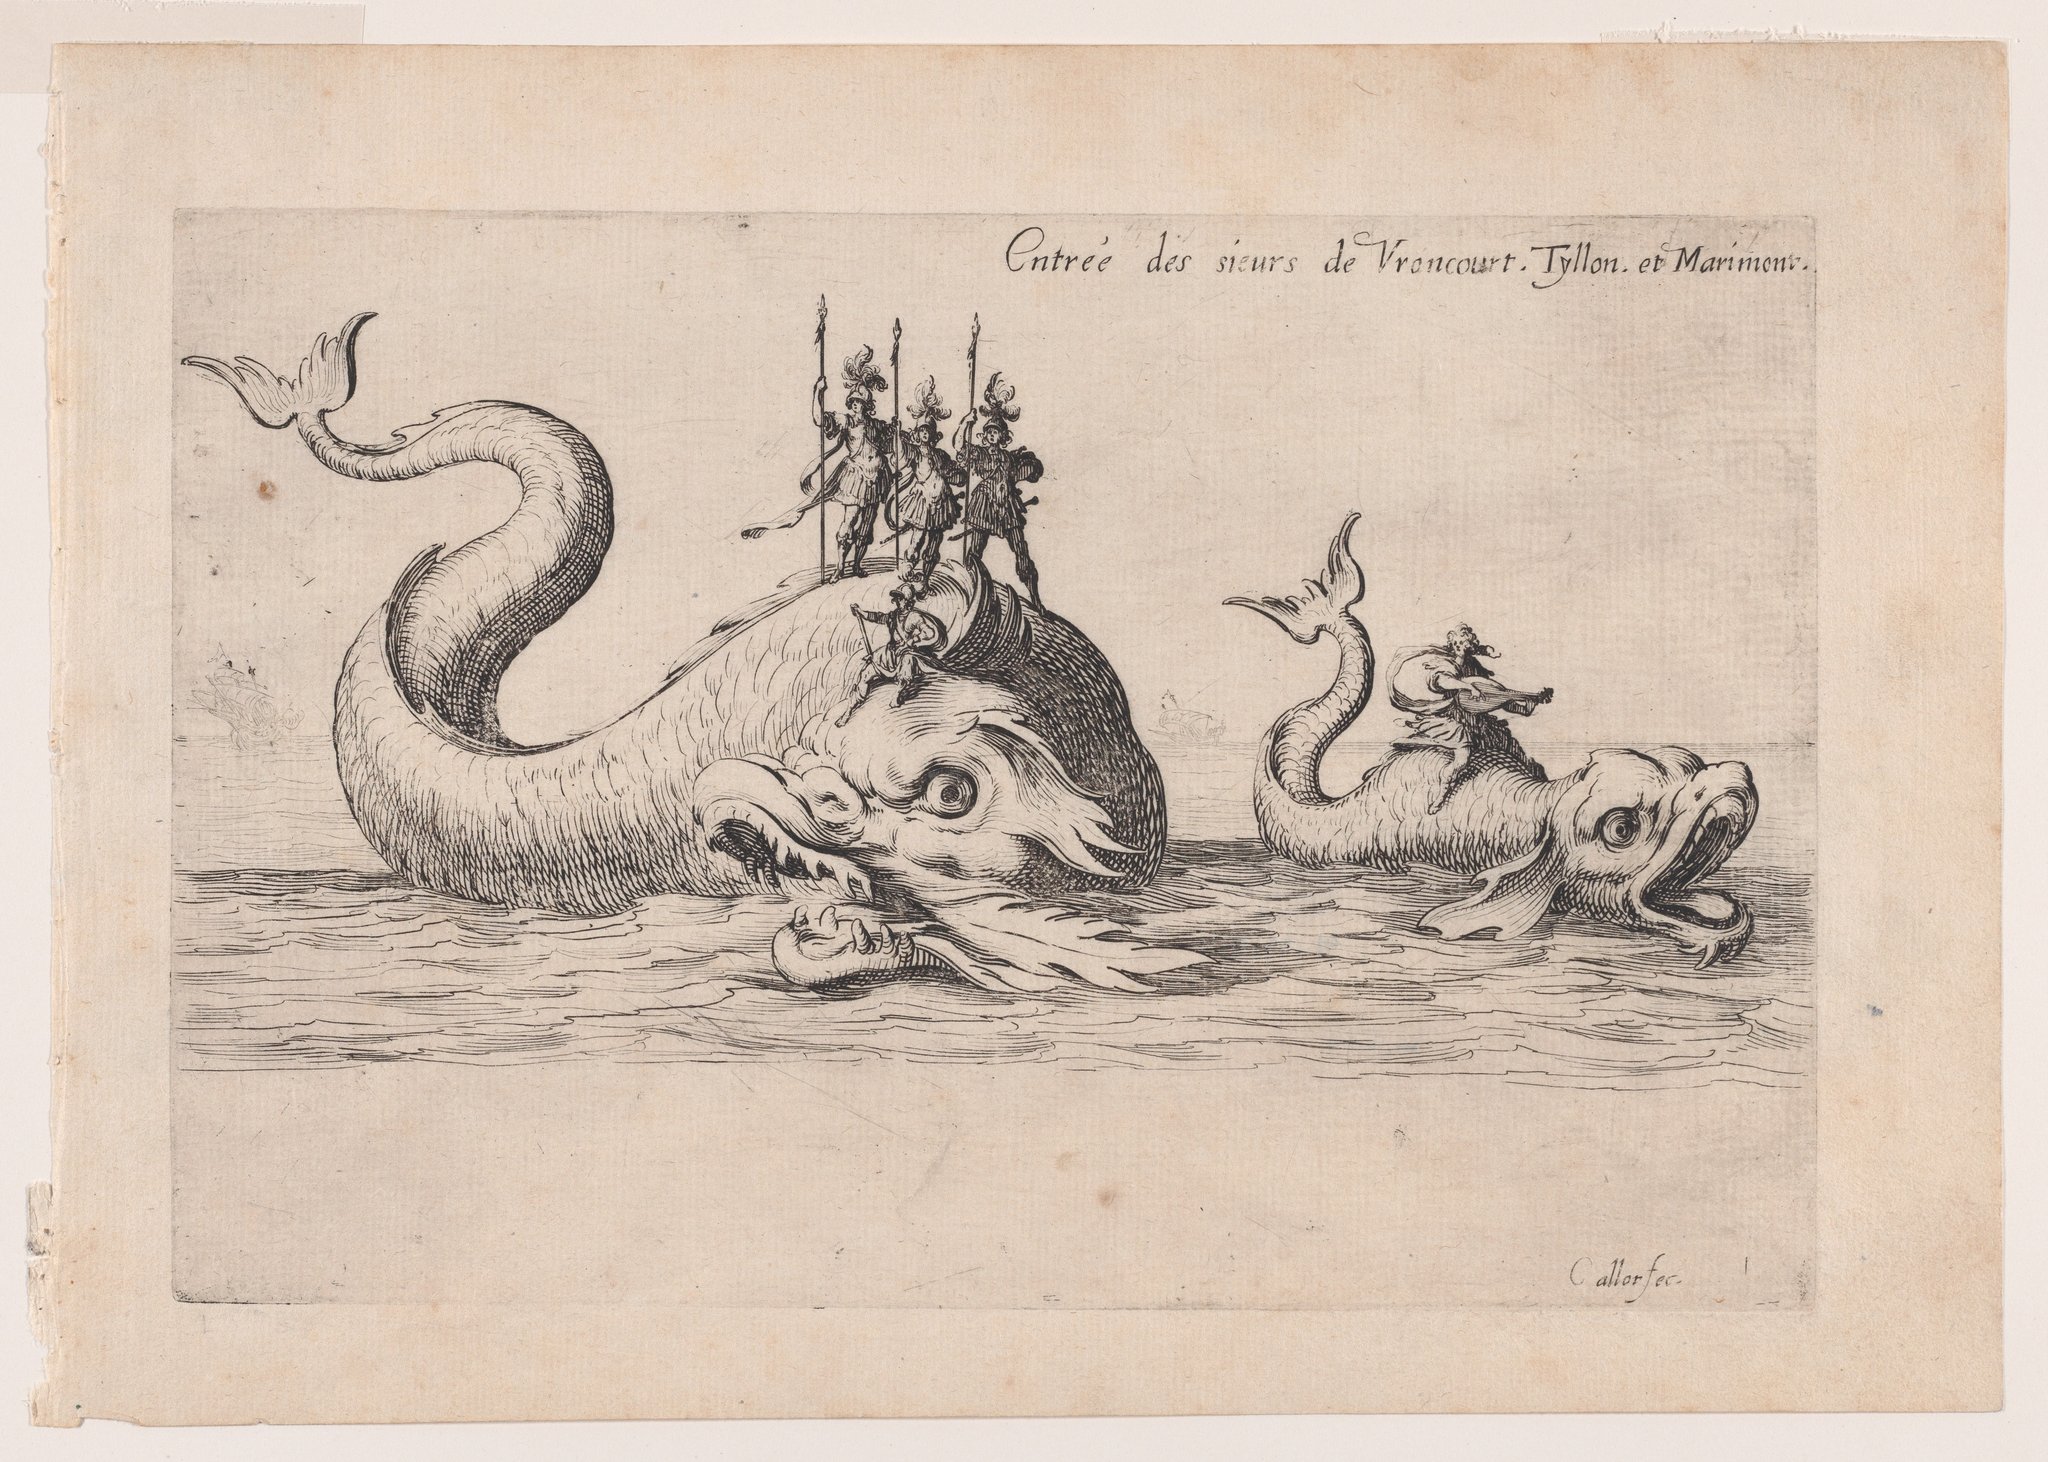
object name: print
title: Entrée de MM. de Vroncourt, Tyllon, et Marimont (Entrances of Monsieur de Vroncourt, of Monsieur de Tyllon, and Monsieur de Marimont), from Le Combat a la Barrière in the Palace at Nancy by Henri Humbert, printed by Sebastien Phillipe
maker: jacques callot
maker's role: artist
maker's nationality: french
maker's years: 1592-1635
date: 1627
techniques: etching